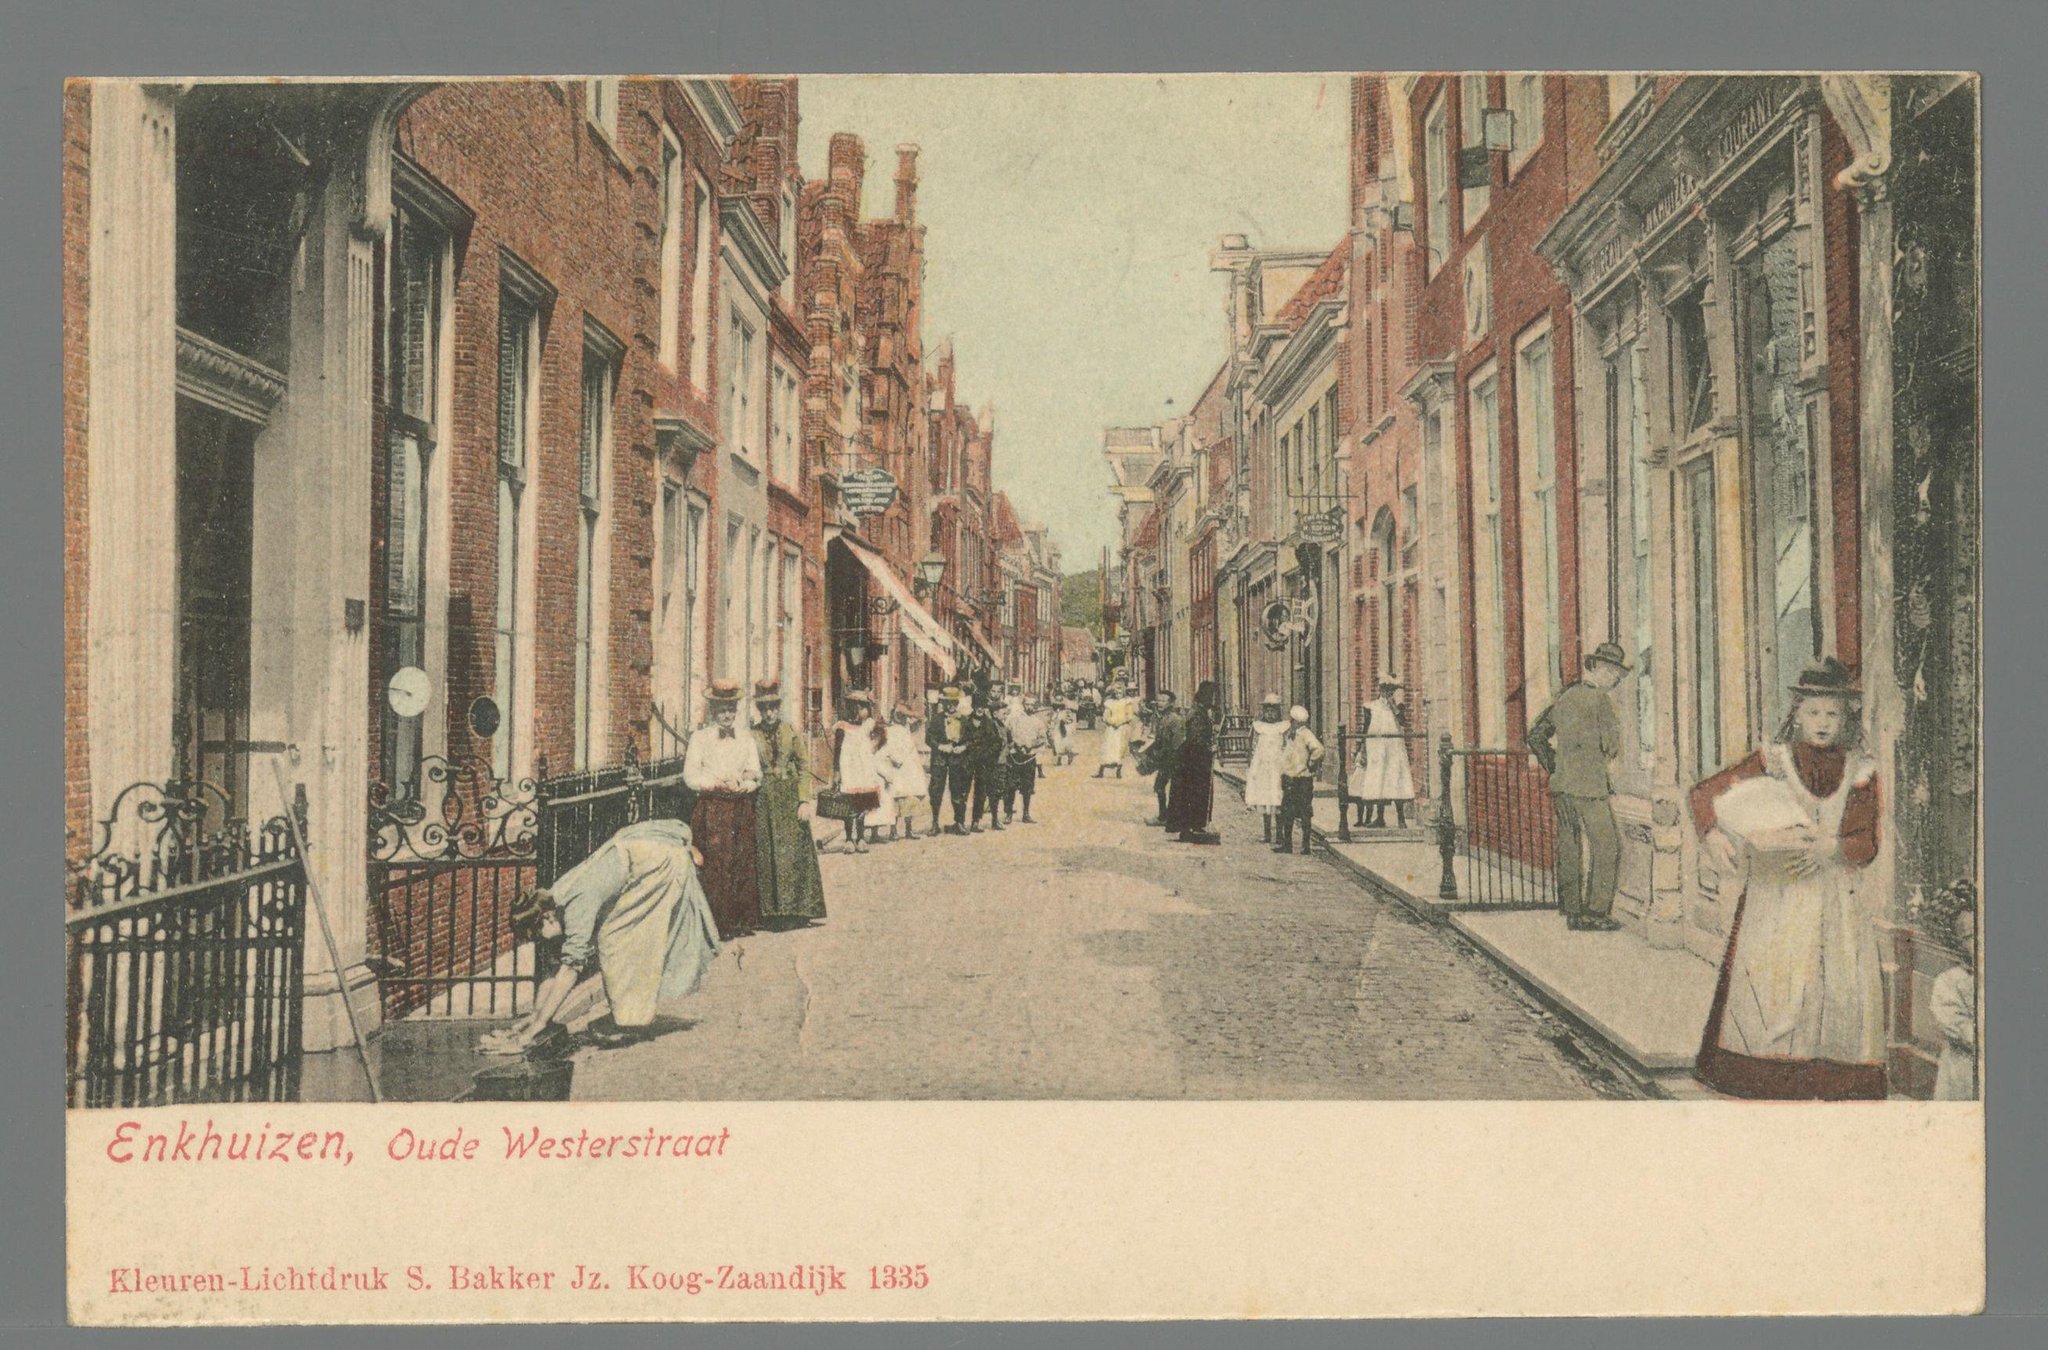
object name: ansichtkaart, prentbriefkaart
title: Enkhuizen, Oude Westerstraat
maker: simon bakker jz.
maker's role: printer, publisher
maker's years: 1873-1930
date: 1899-1905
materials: cardboard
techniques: photograph, lithograph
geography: koog aan de zaan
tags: city-view, and landscape with man-made constructions, street, enkhuizen